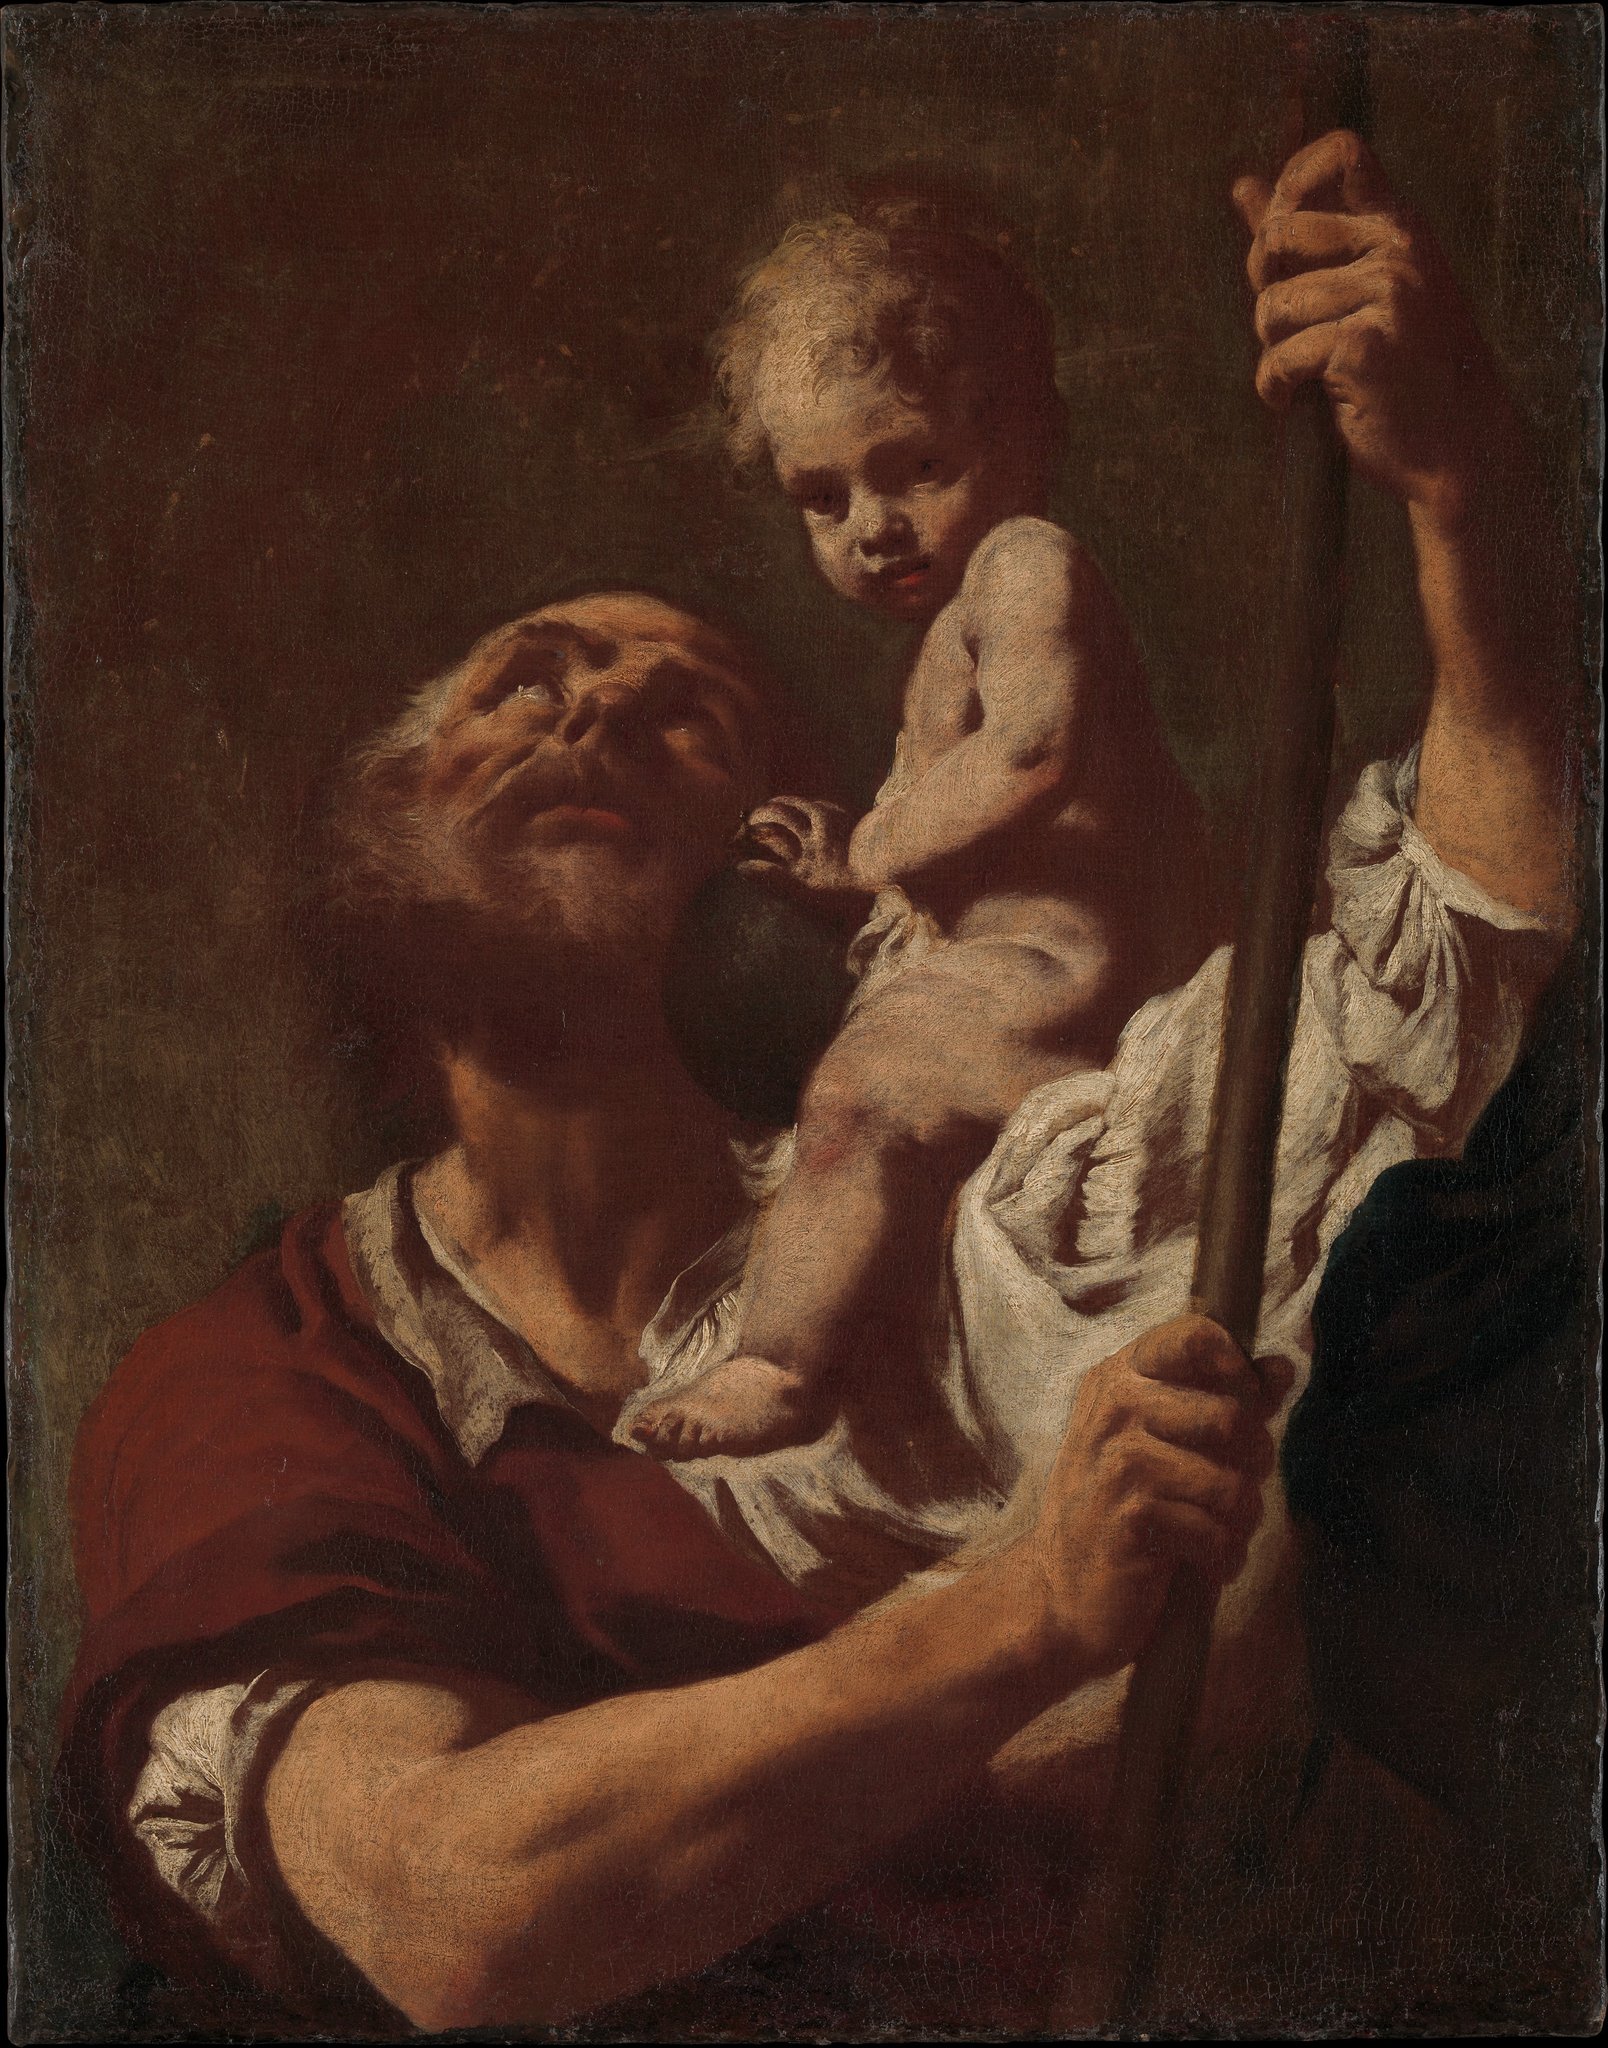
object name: painting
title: Saint Christopher Carrying the Infant Christ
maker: giovanni battista piazzetta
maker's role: artist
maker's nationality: italian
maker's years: 1682-1754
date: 1730-1739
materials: canvas, oil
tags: saint christopher,jesus